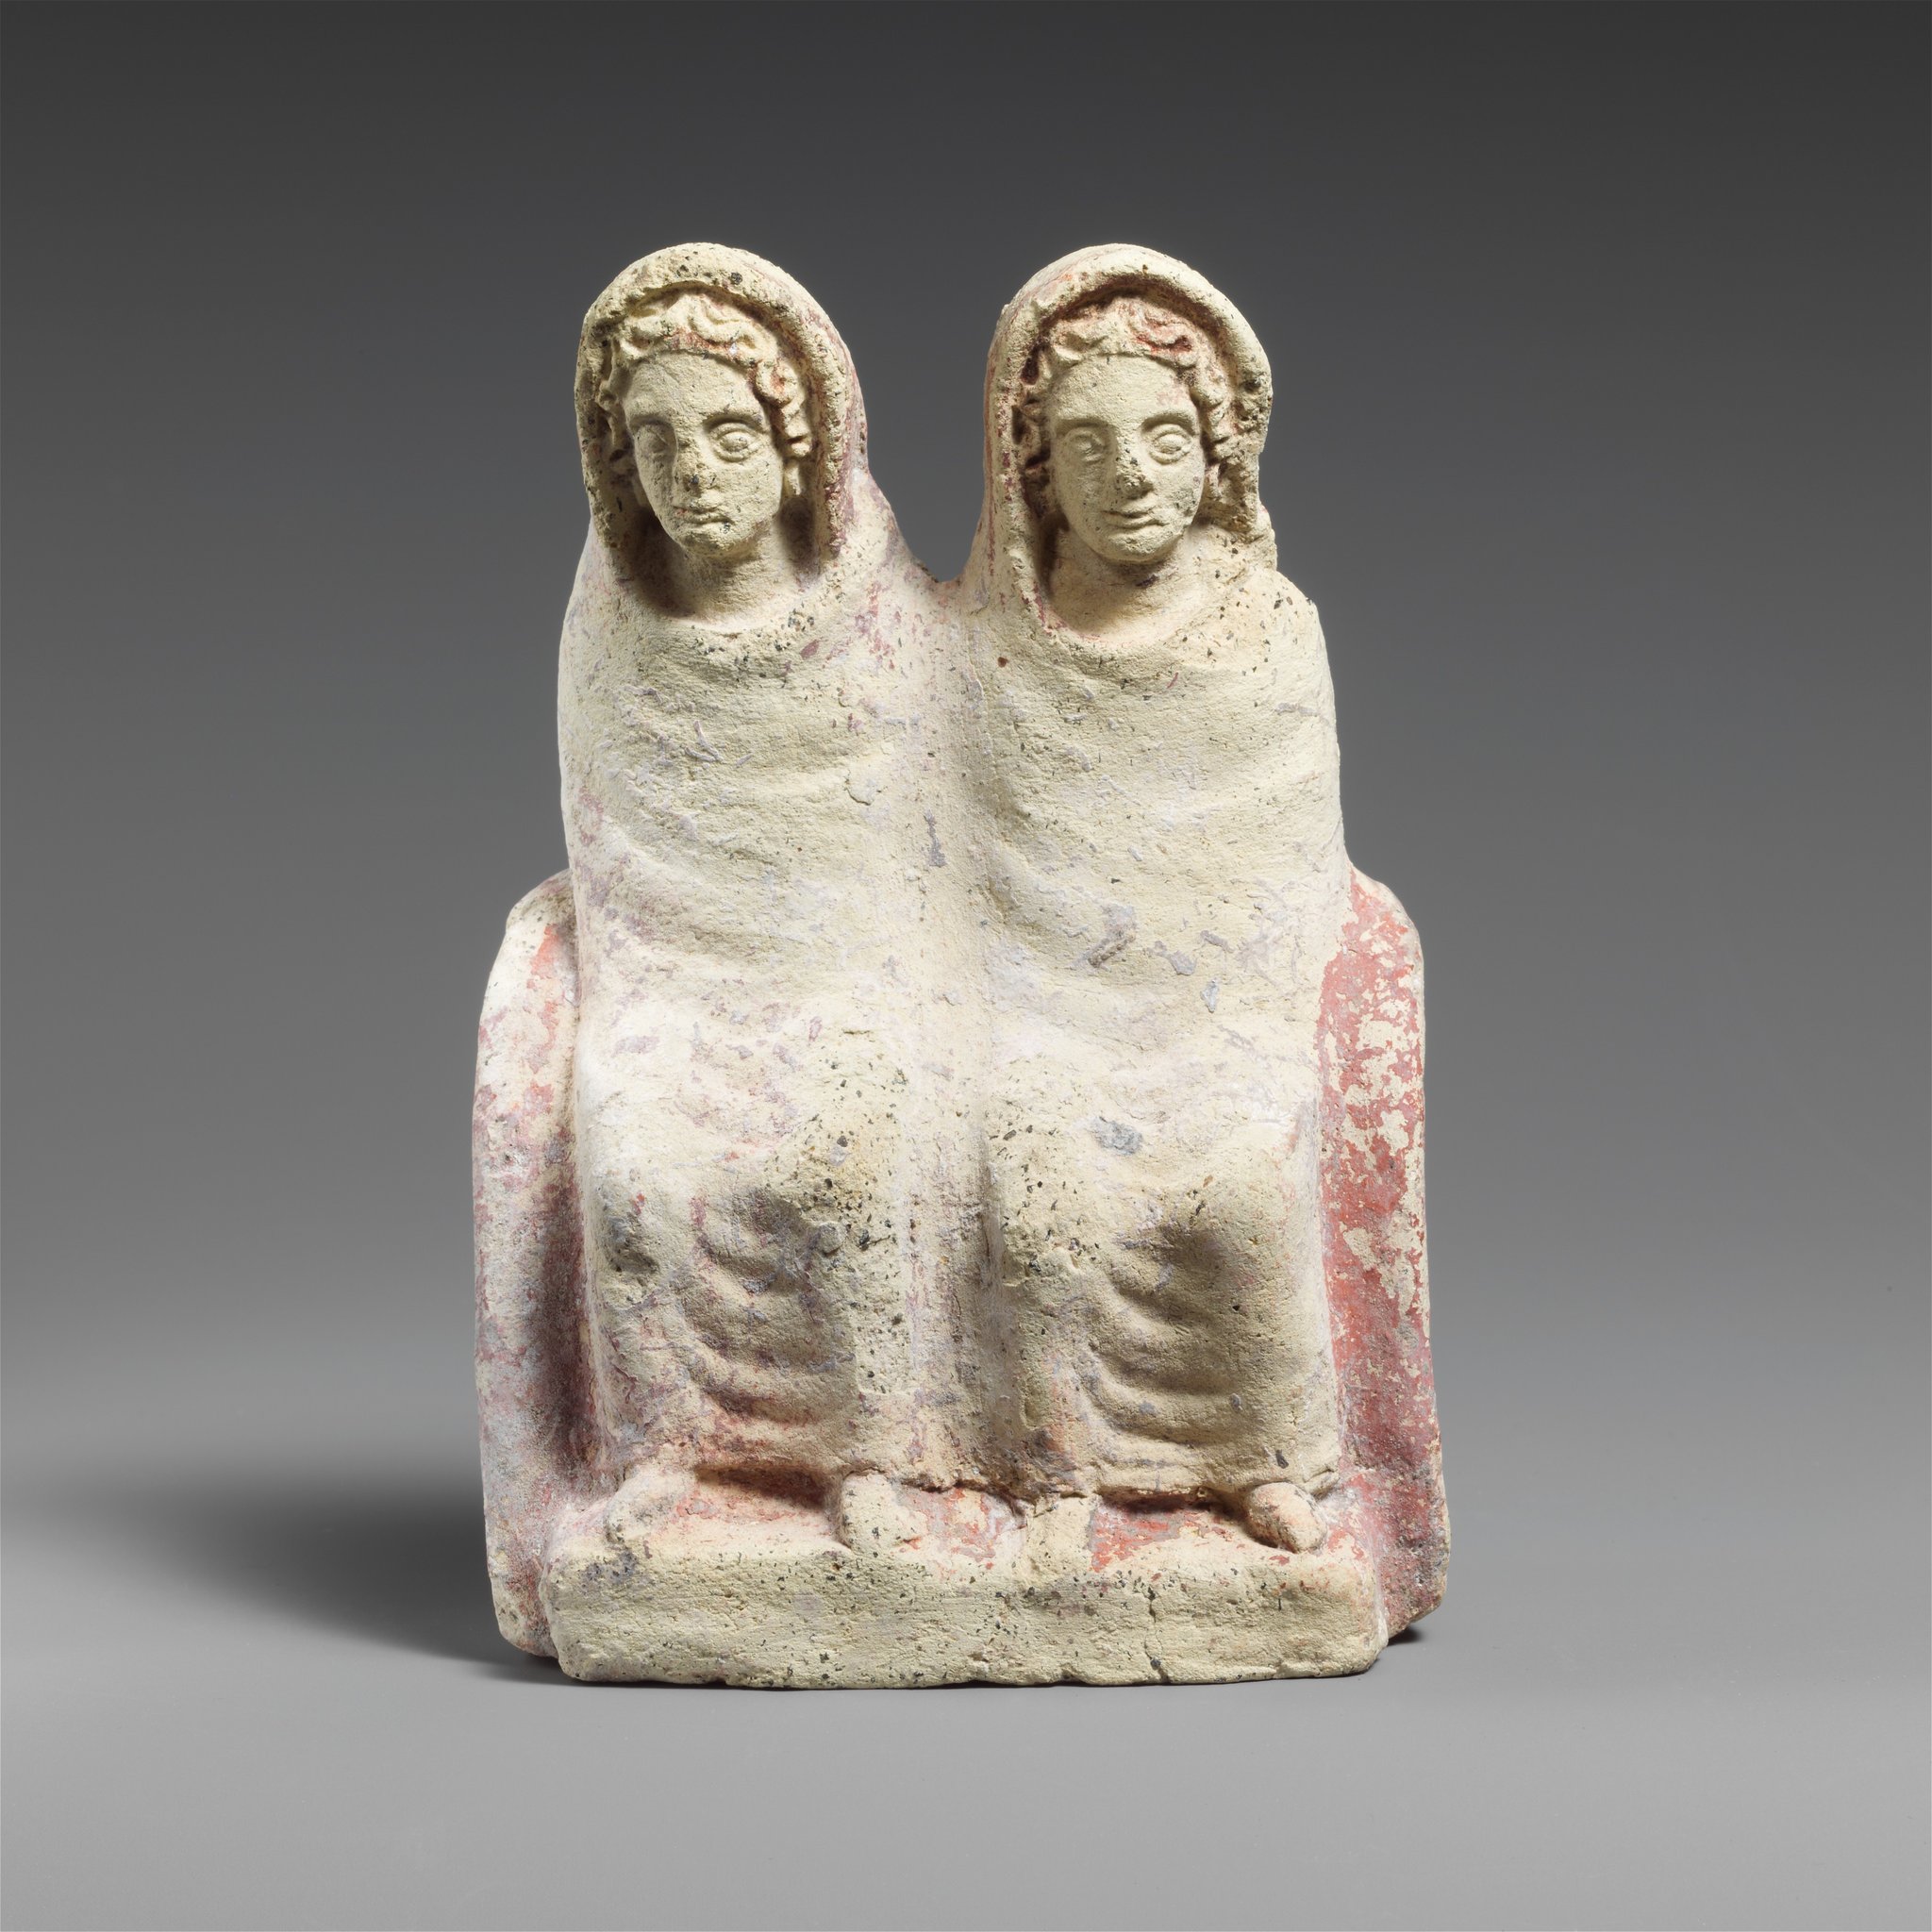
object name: statuette of two goddess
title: Terracotta votive statuette of two draped females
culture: etruscan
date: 400-201 BCE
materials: terracotta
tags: women